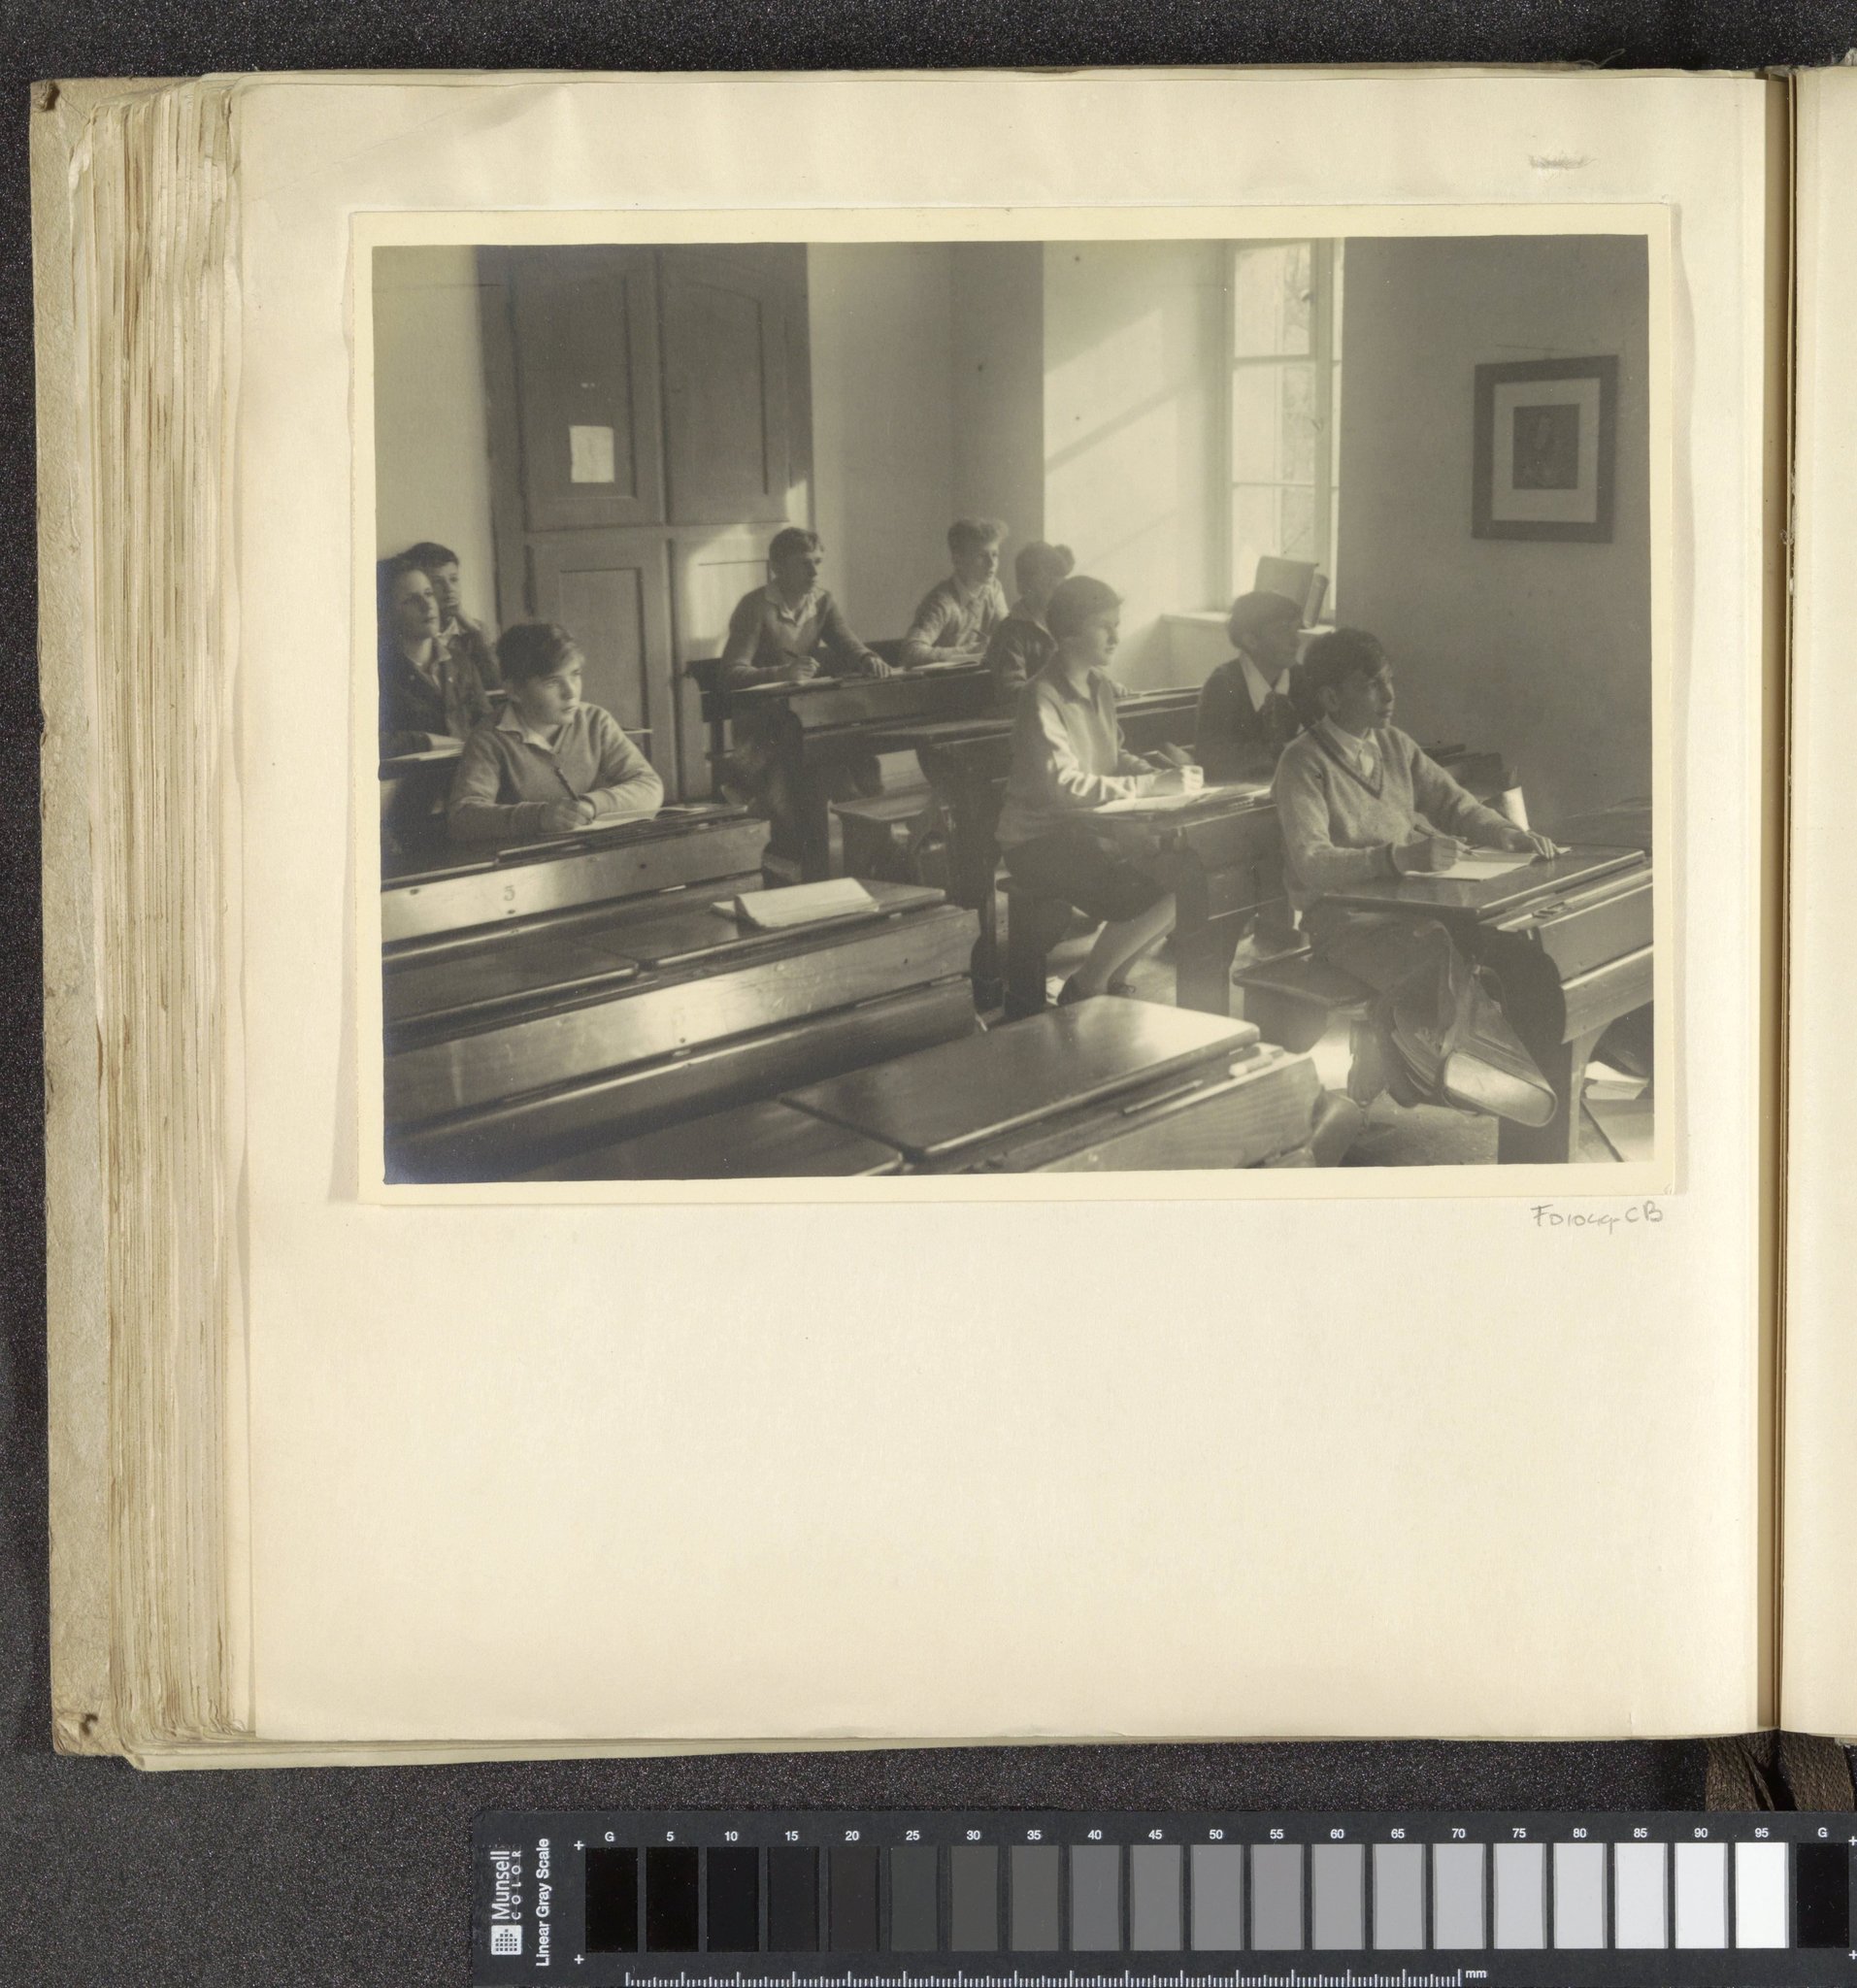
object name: photograph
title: Jonge leerlingen zittend in een klaslokaal in Hermannsberg, een nevenvestiging van Schule Schloss Salem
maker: Anonymous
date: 1929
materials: photographic support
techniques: gelatin silver print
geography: hermannsberg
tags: education, elementary school; class, form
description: Onderdeel van Fotoalbum van Schule Schloss Salem.